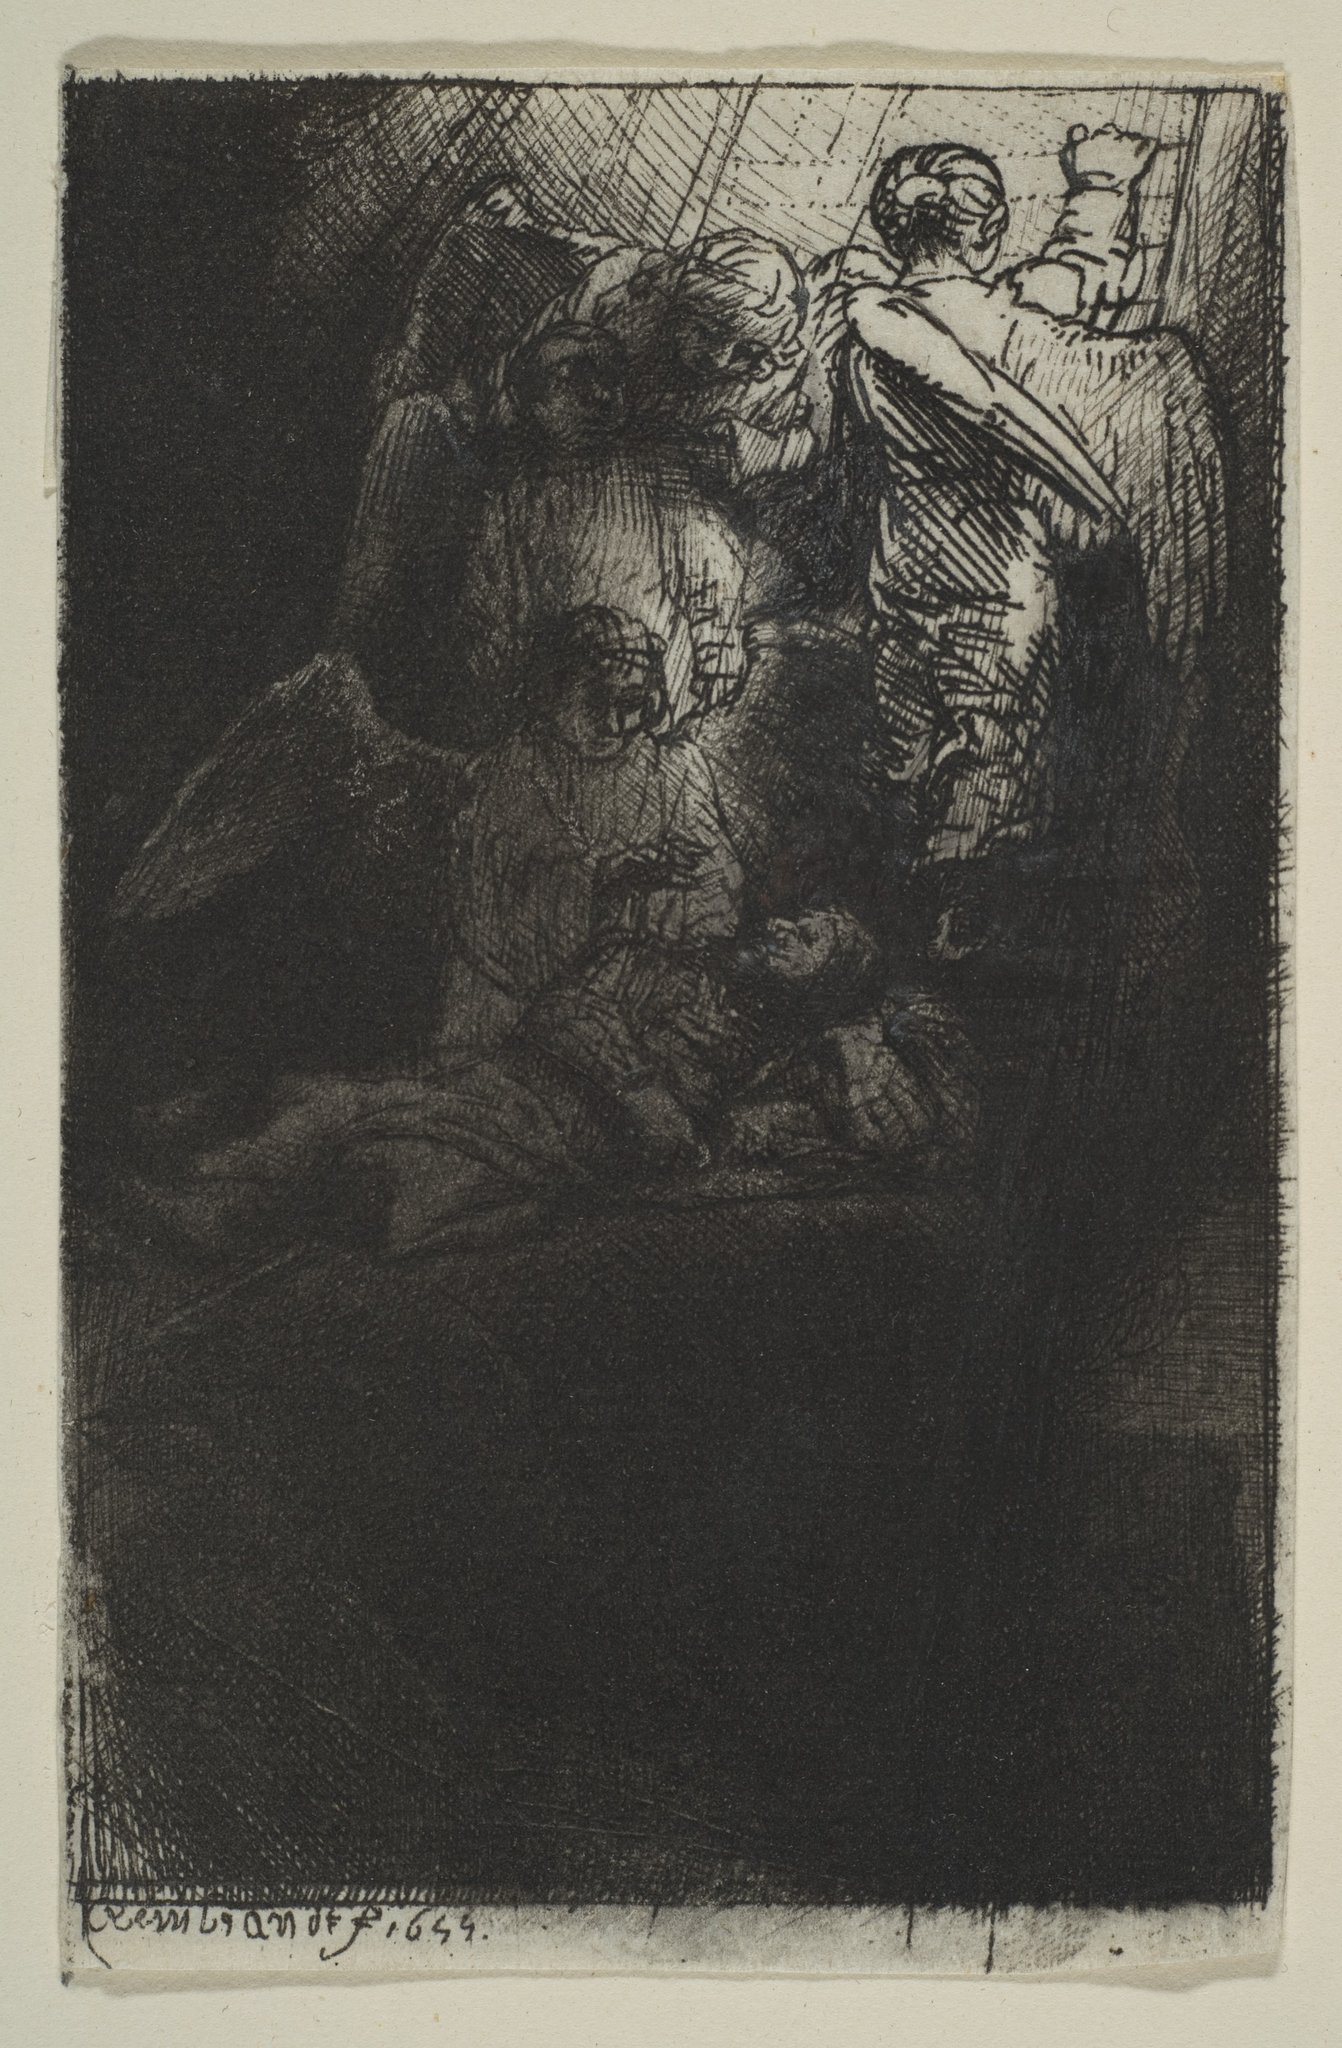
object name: print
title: Jacob's Ladder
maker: rembrandt van rijn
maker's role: artist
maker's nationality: dutch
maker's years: 1606-1669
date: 1655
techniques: engraving, drypoint, etching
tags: men,angels